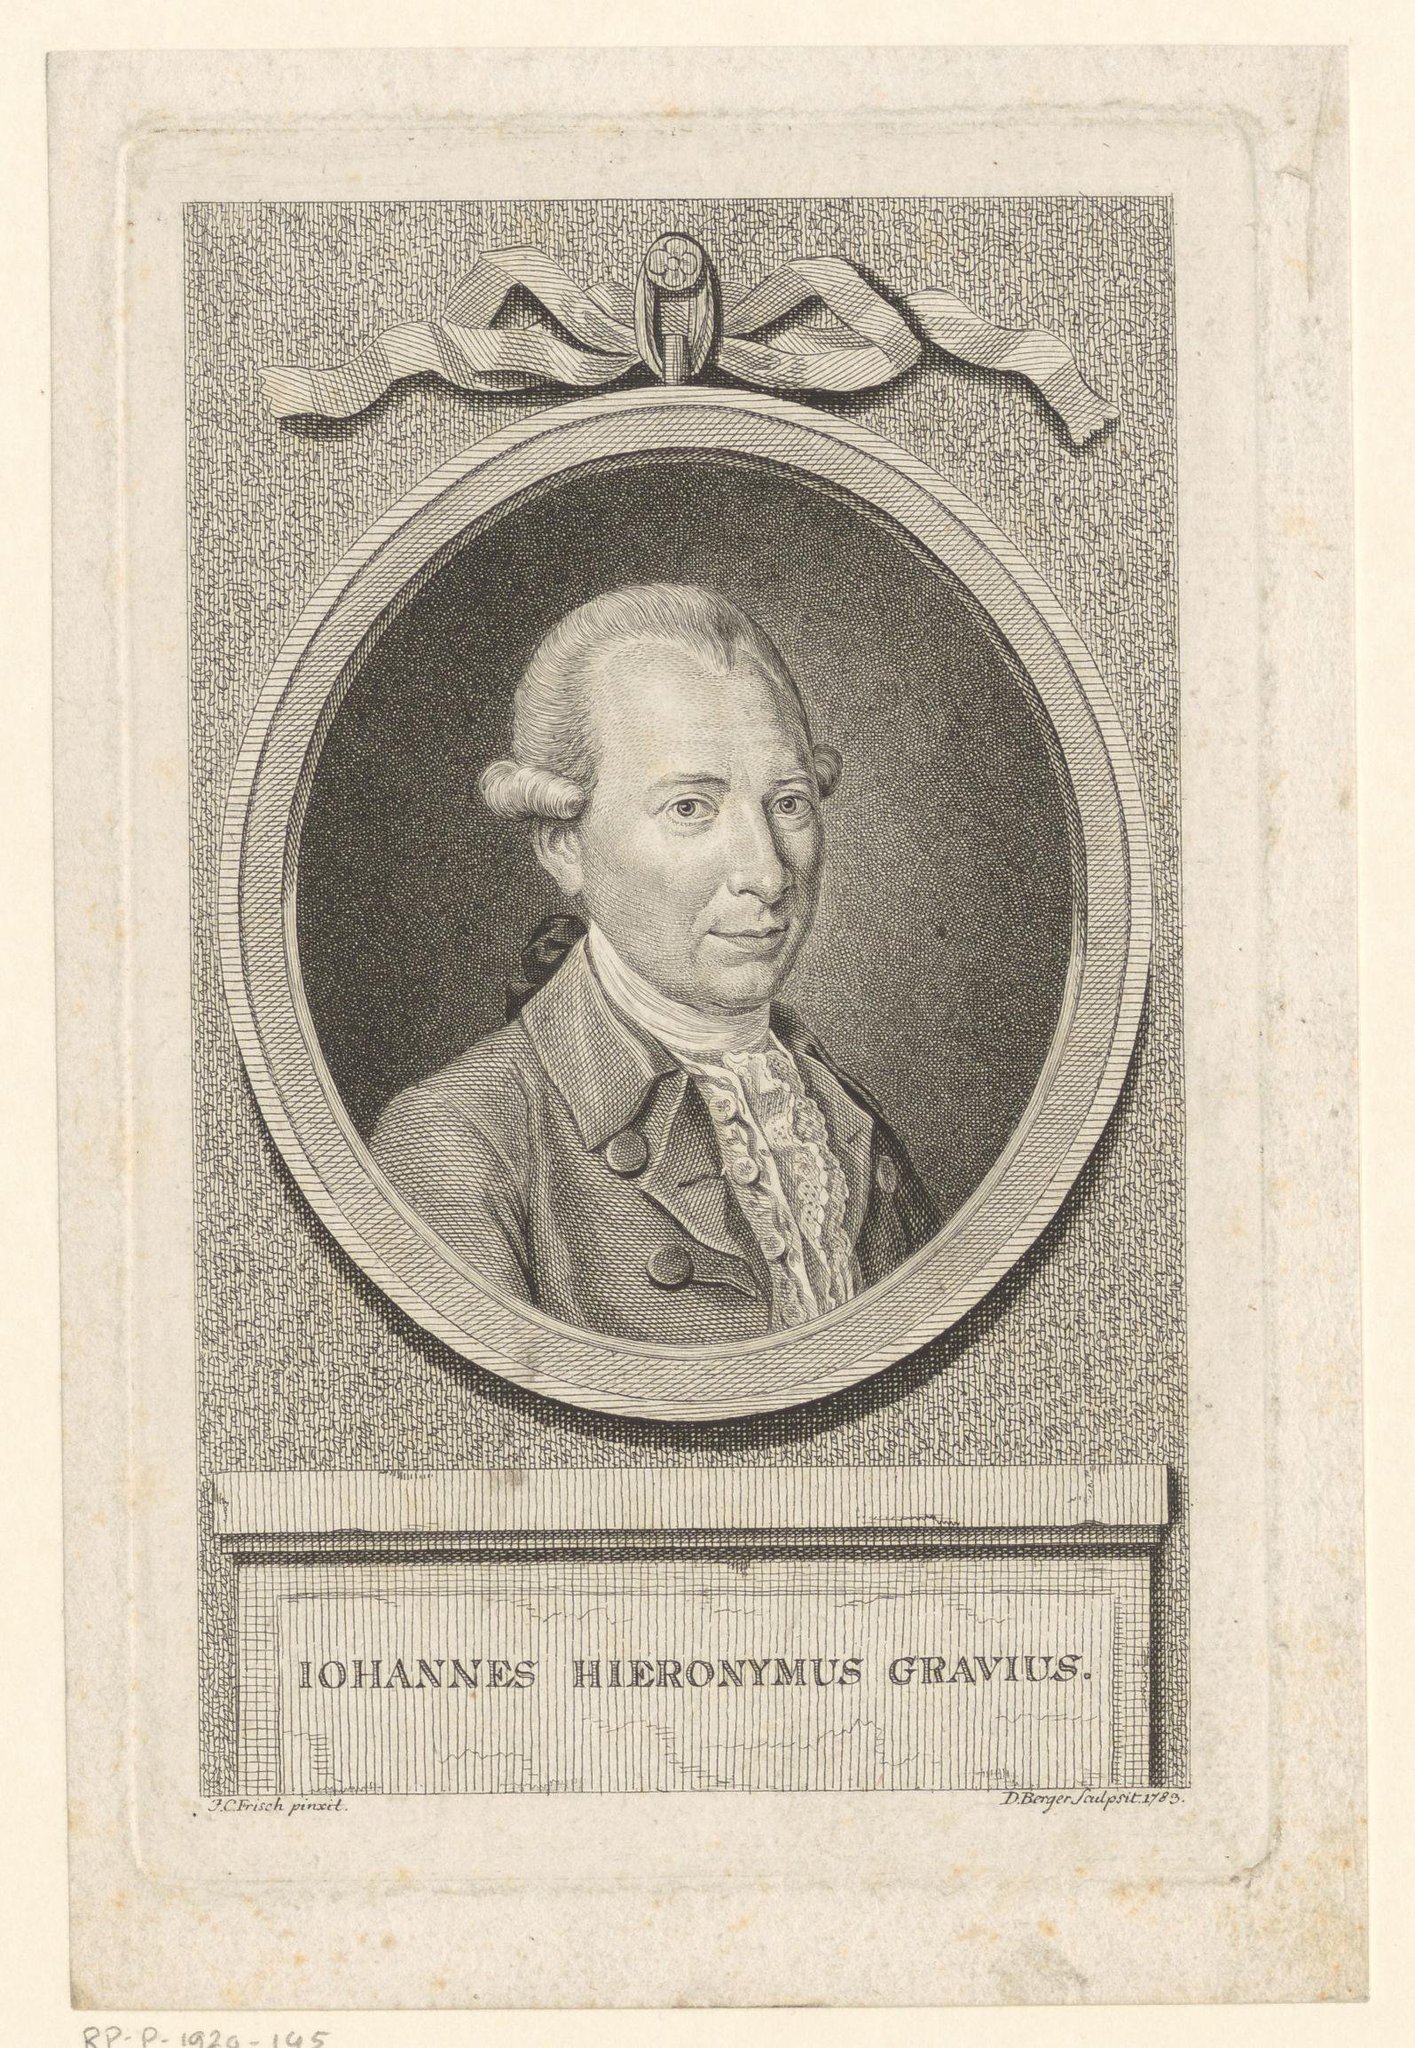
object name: print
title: Portret van Johann Hieronymus Graf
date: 1783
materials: paper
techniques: engraving, etching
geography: berlin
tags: historical persons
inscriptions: collector's mark: Lugt 2228